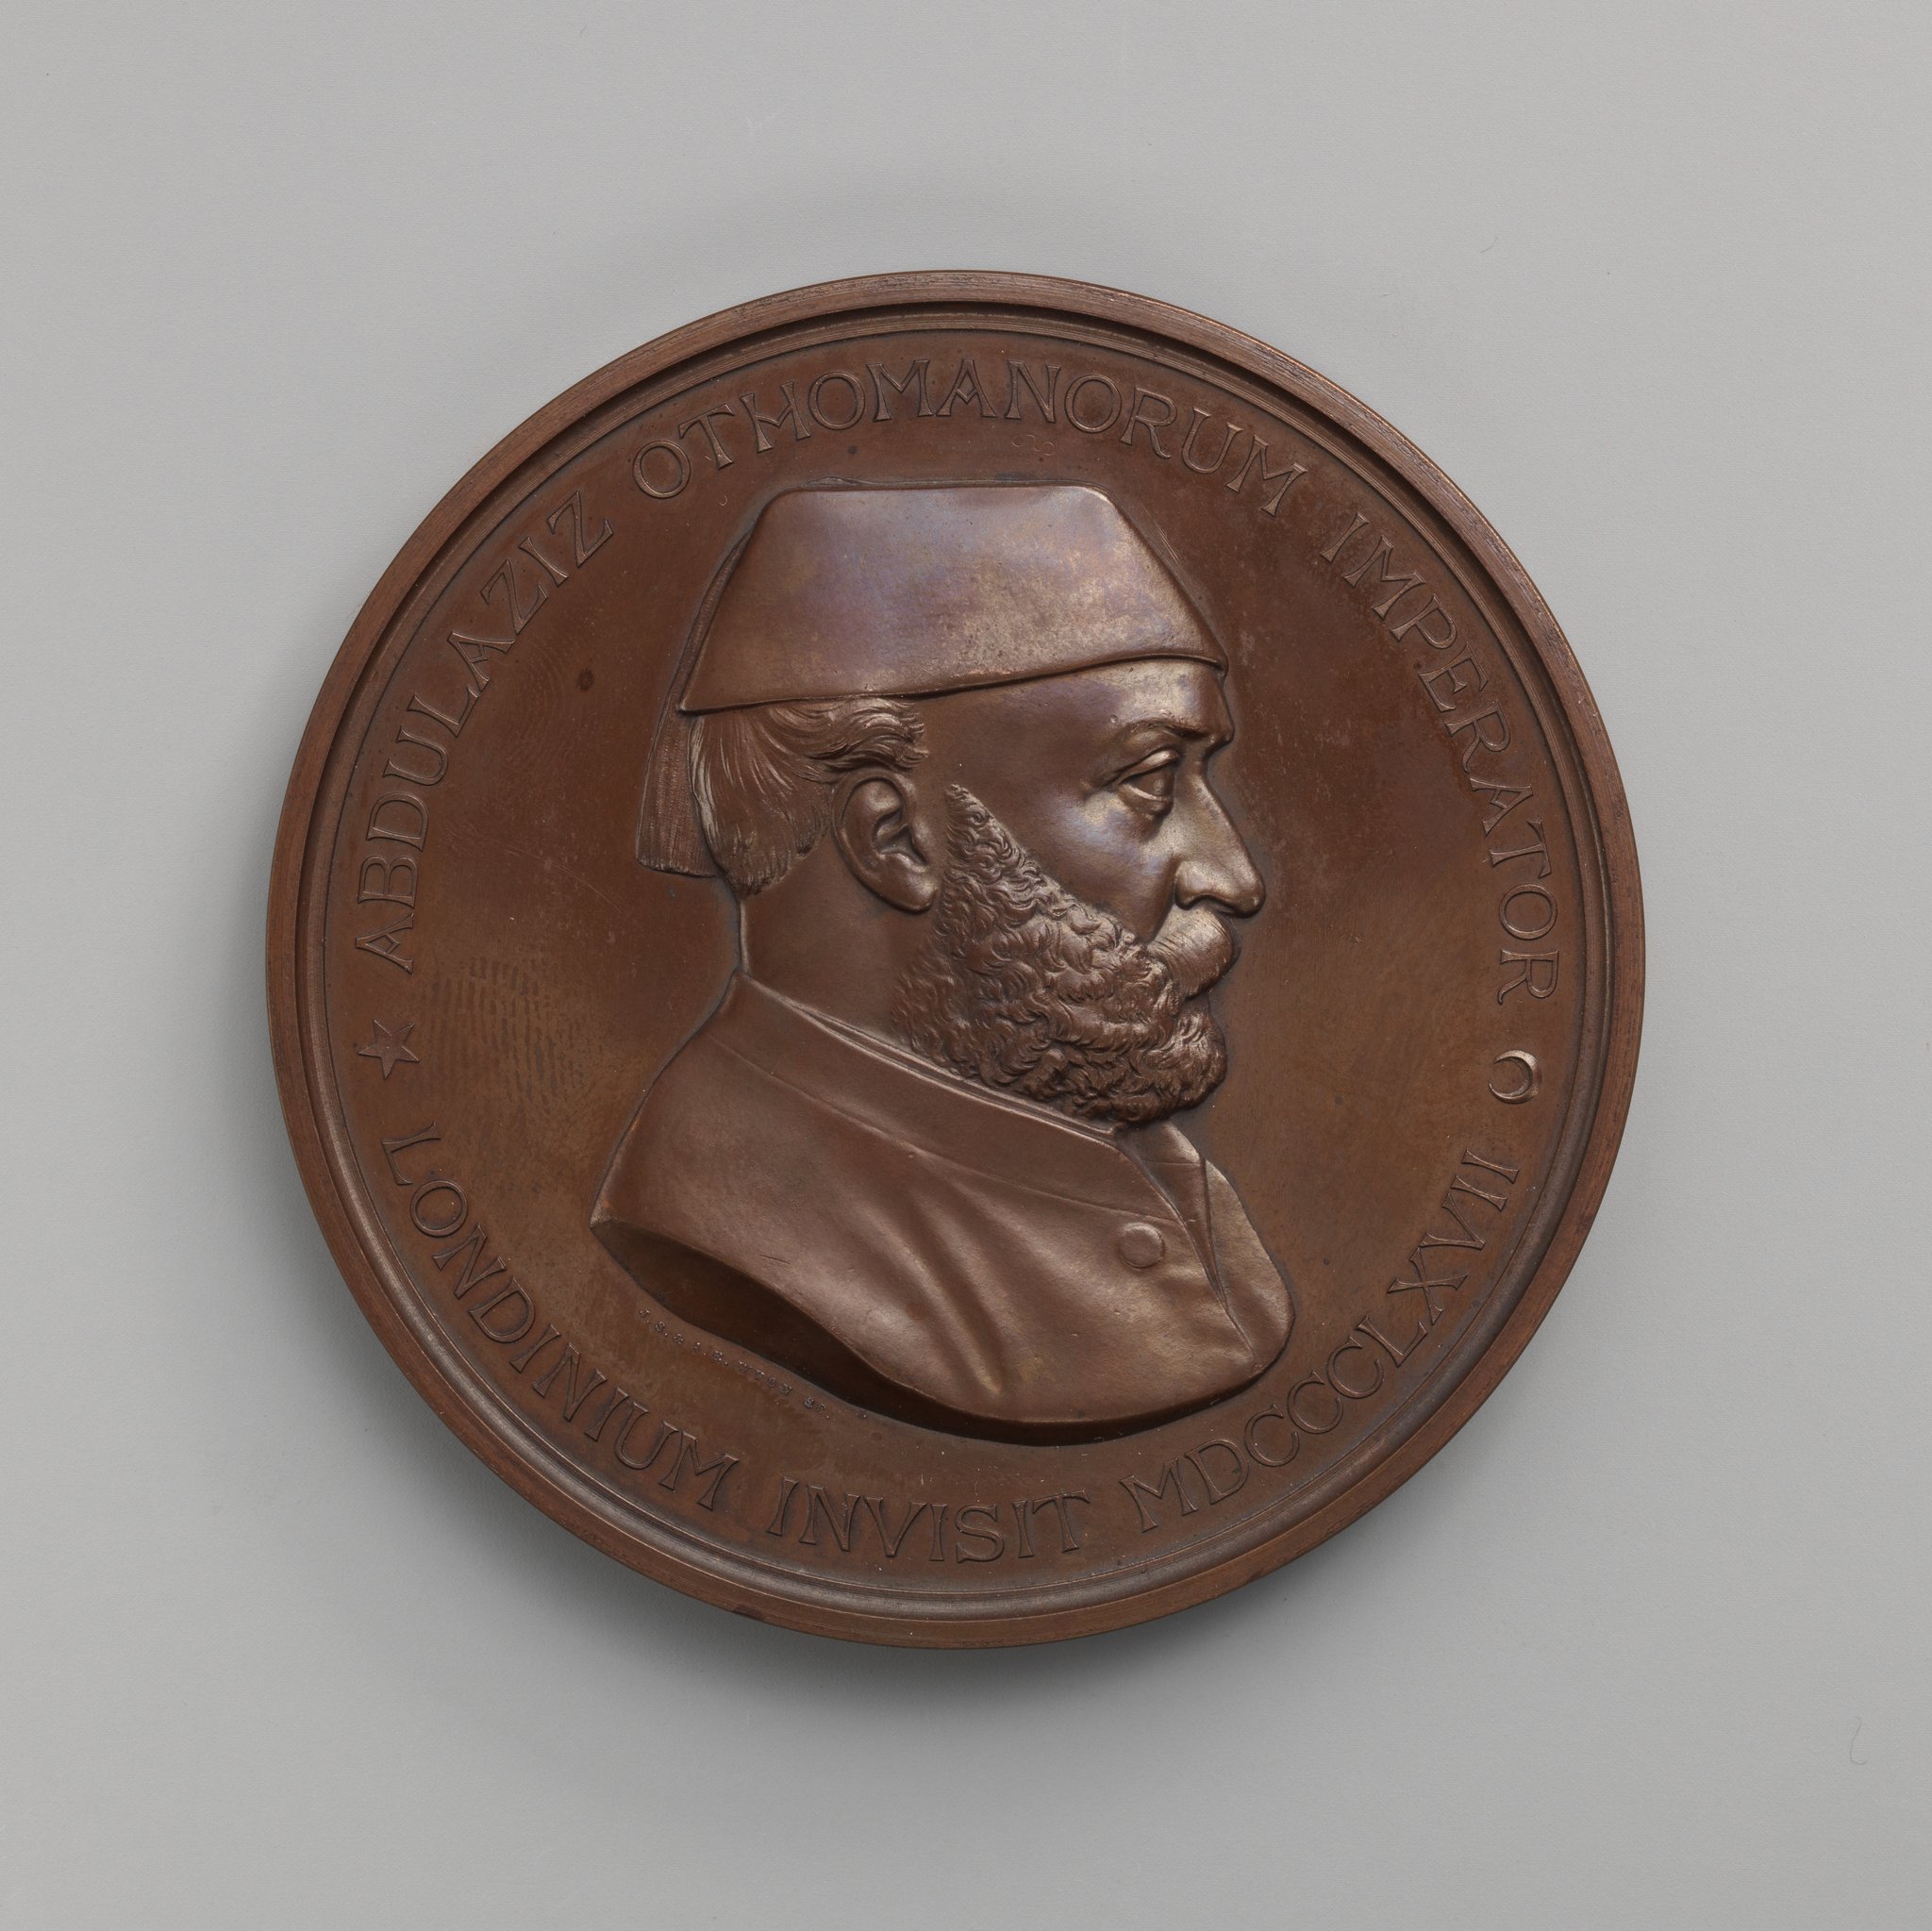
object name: medal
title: In Memory of the Visit of the Turkish Sultan Abdul-Aziz to London, 1867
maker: alfred benjamin wyon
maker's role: artist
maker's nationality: british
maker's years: 1837-1884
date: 1867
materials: bronze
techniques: struck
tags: men,profiles